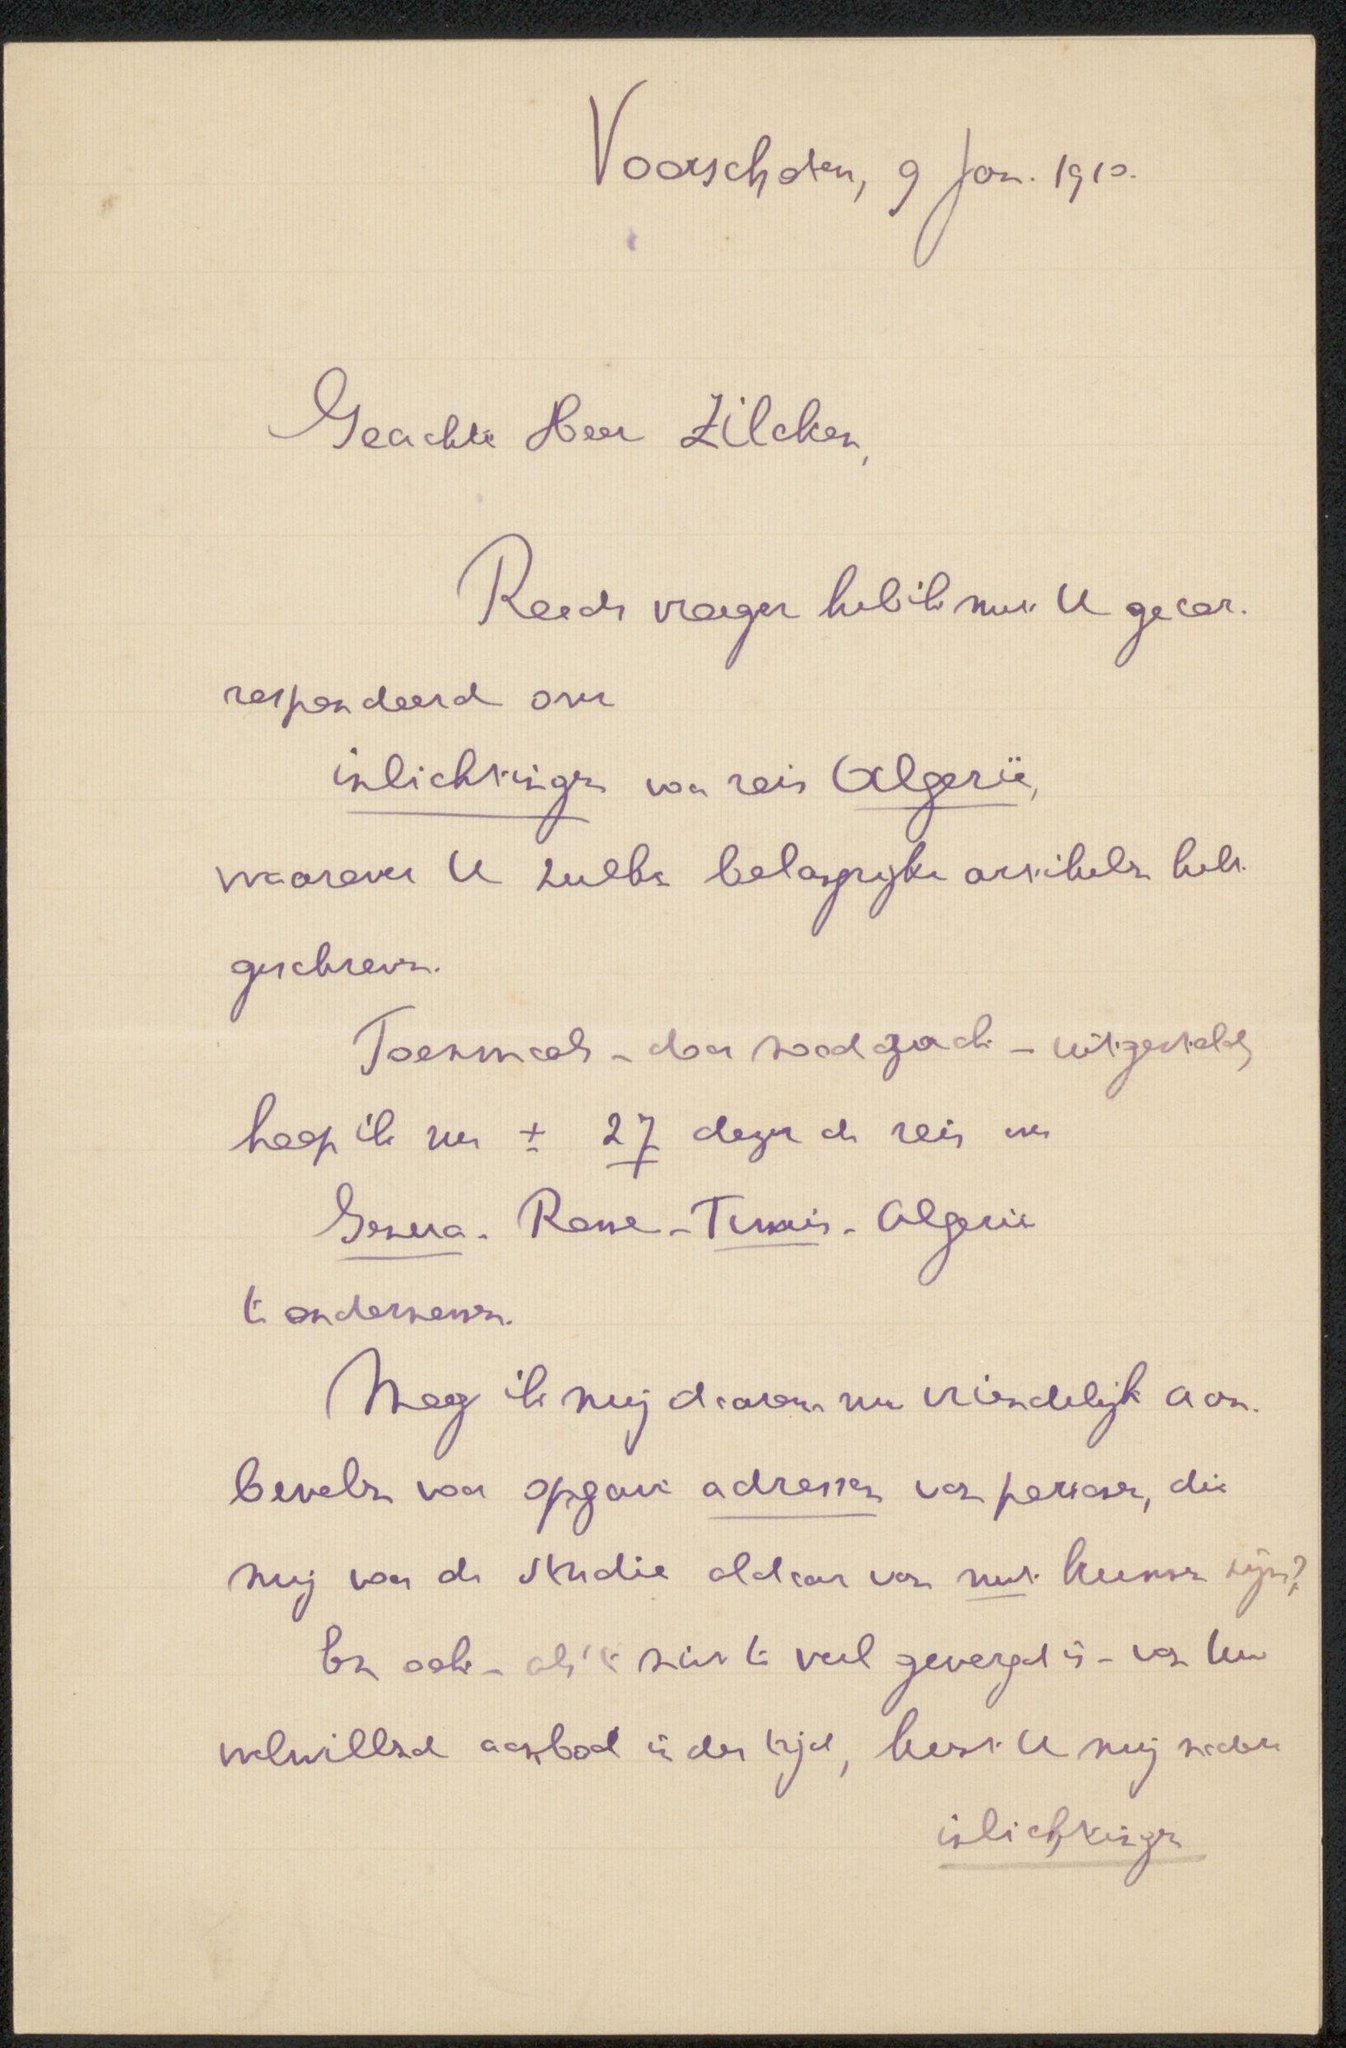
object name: letter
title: Brief aan Philip Zilcken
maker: hendrikus hubertus van kol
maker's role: engineer, politician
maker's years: 1852-1925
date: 1910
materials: ink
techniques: pen, writing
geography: voorschoten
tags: the hague, painter, draughtsman, philip zilcken, travelling; tourism, rome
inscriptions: collector's mark: ‘RPK’